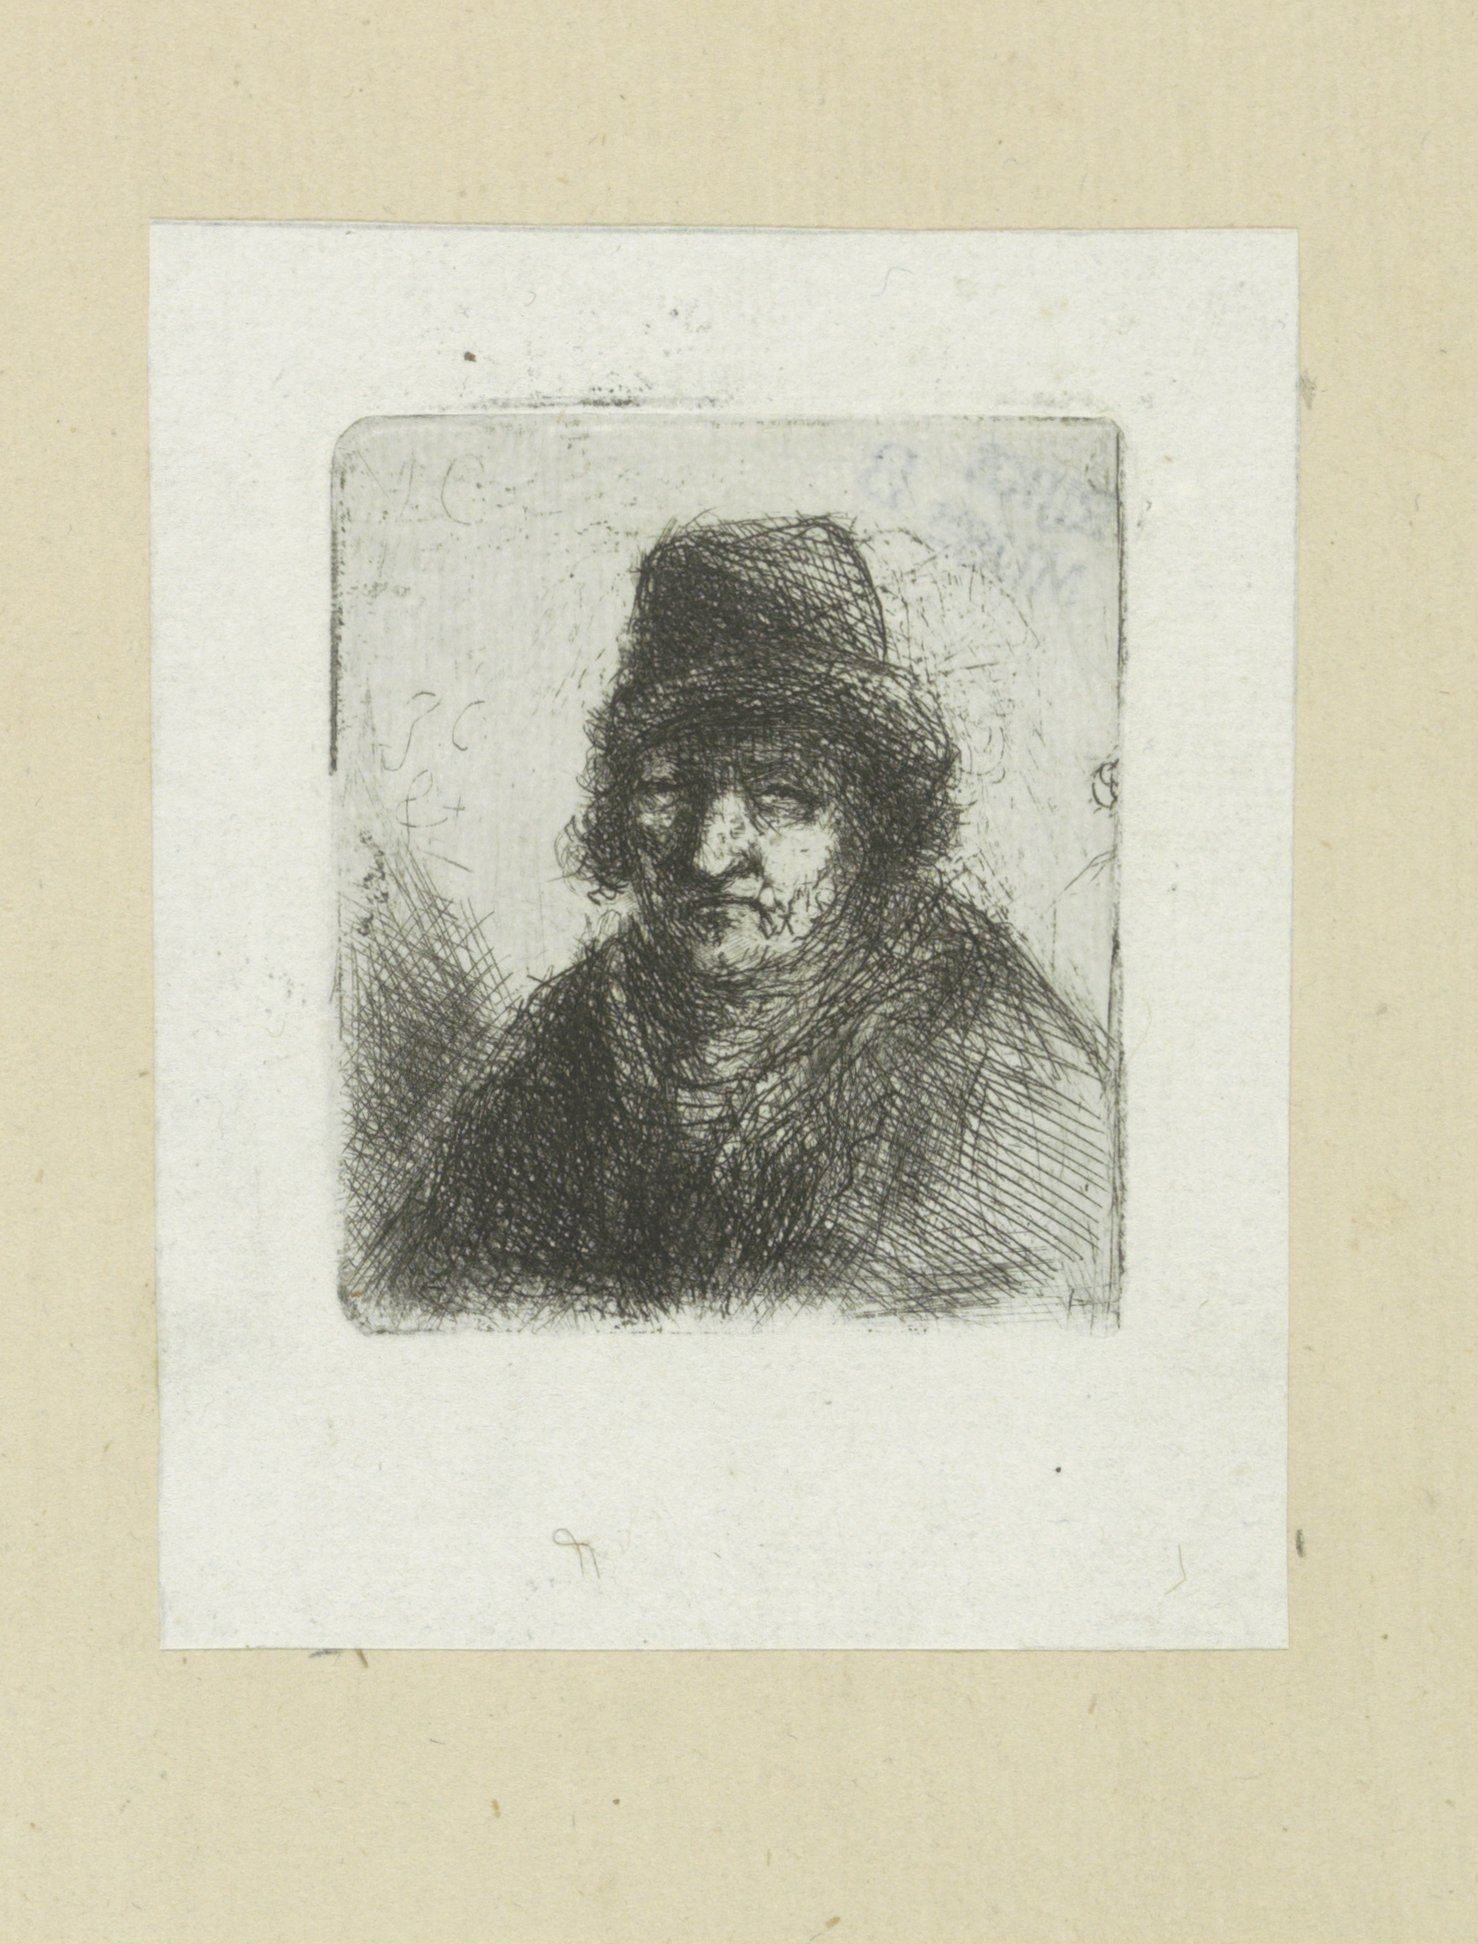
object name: print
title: Volwassen man met hoed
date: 1802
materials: paper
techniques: drypoint, etching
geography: london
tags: morphology of human expression (+ adult male (human being))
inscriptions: collector's mark: ‘RIJKS / MUSM’, collector's mark: ‘B’